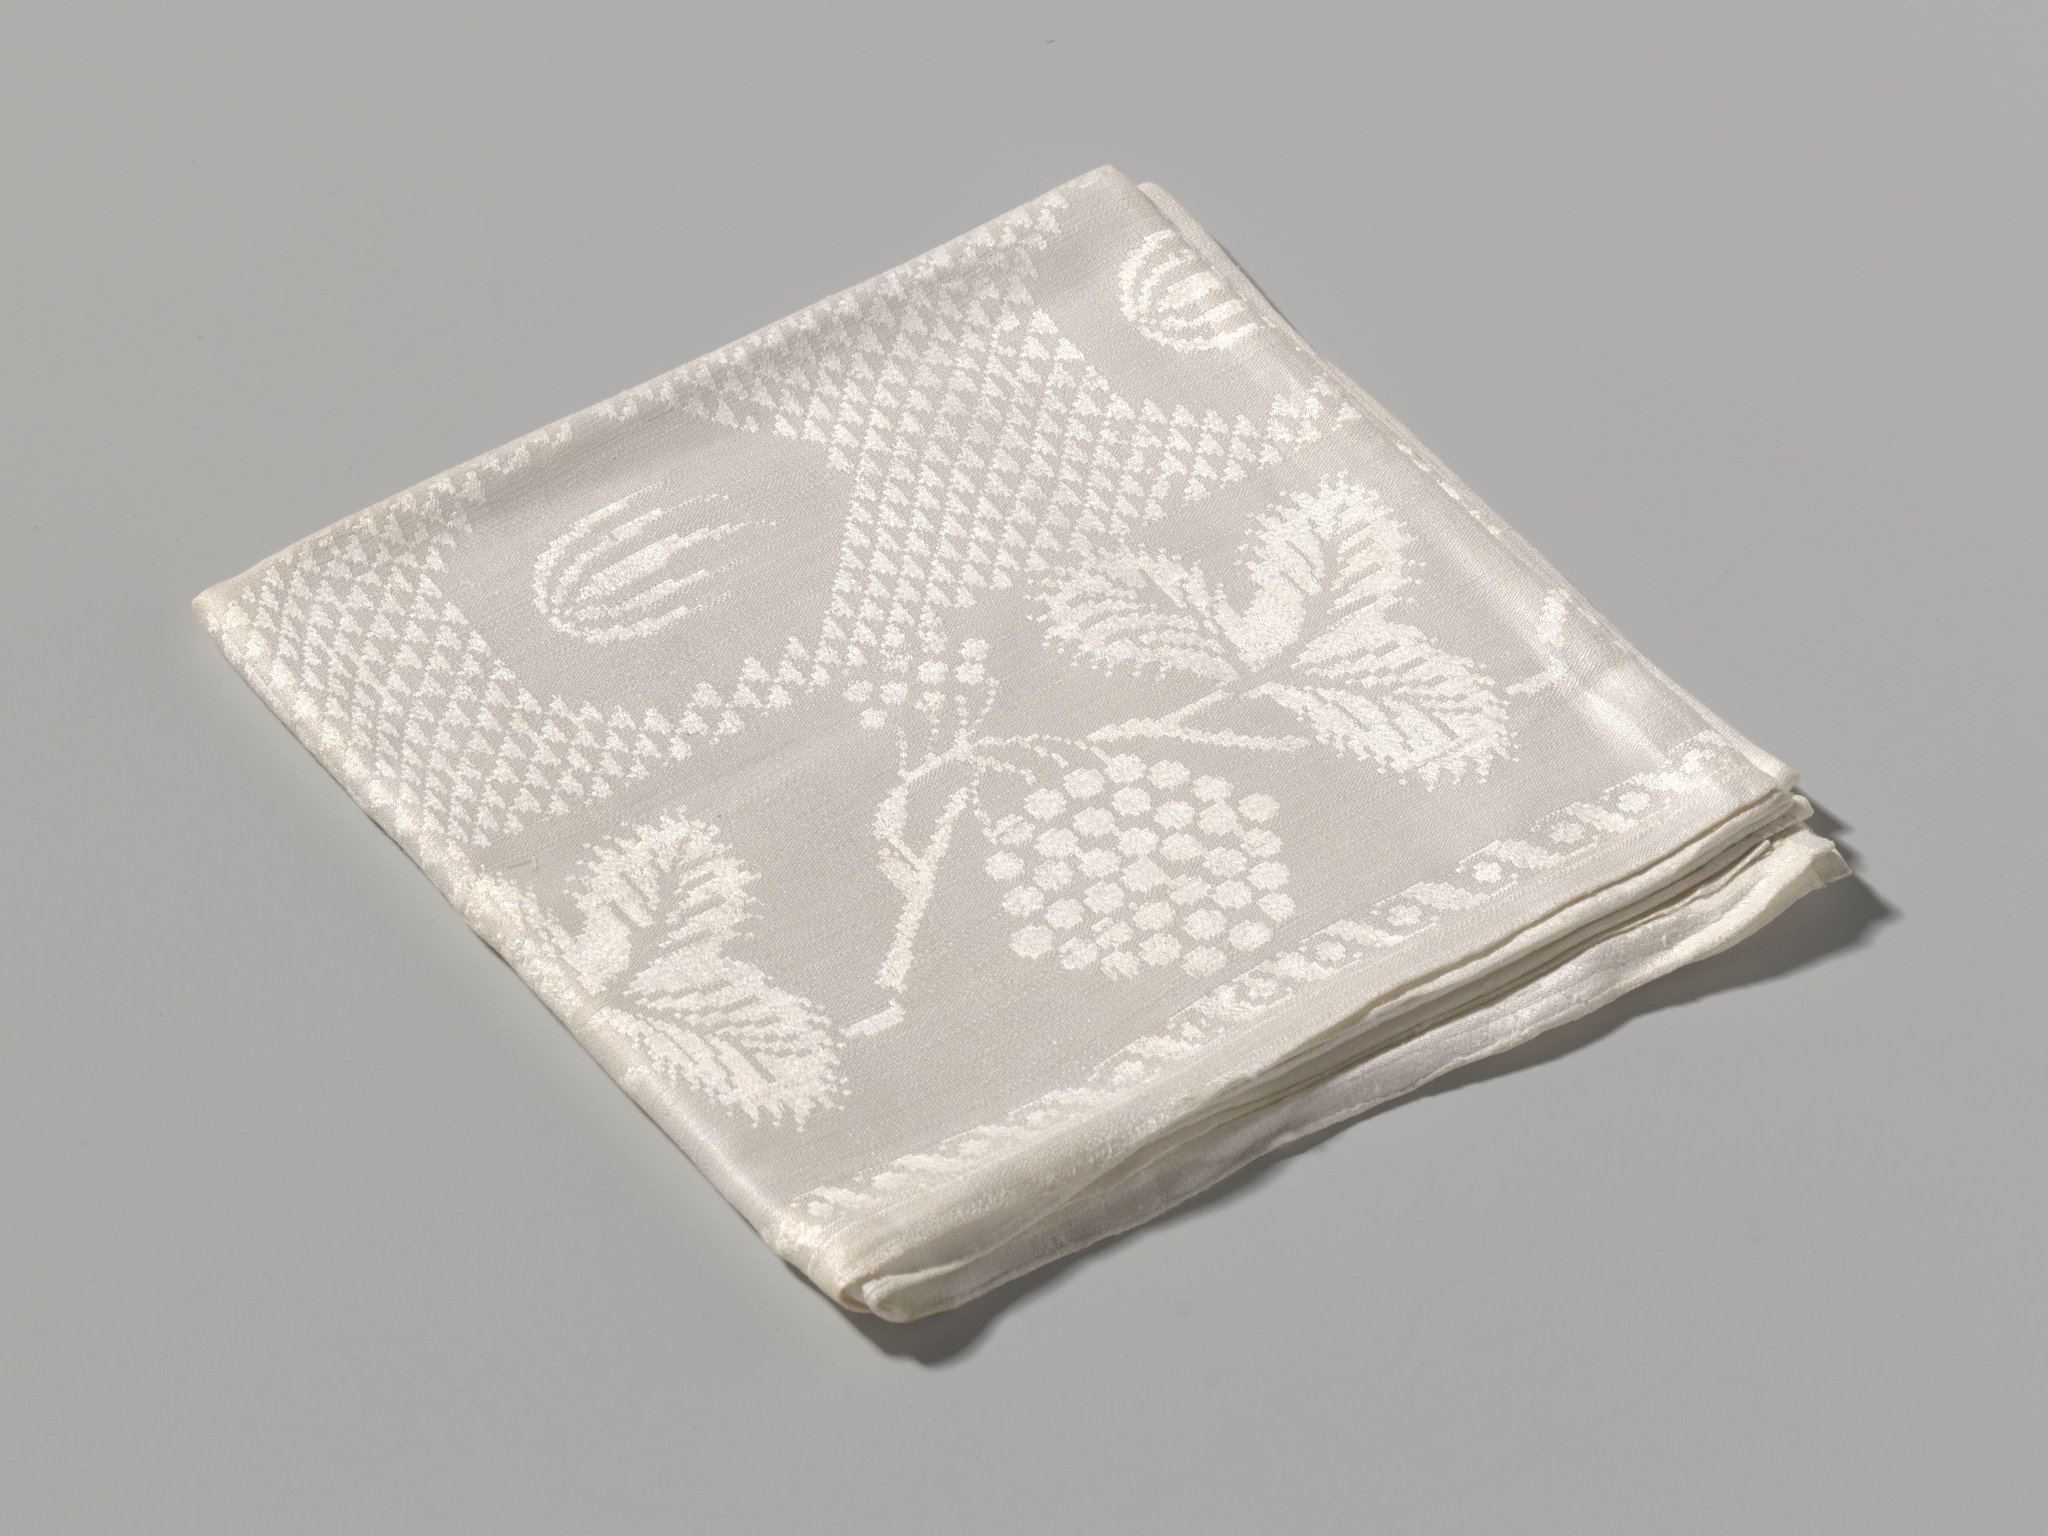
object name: napkin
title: Servet met rand van druivenranken en een geschaakt midden met inzetten.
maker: Anonymous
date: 1825-1850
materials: linen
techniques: damask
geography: germany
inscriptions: mark: ‘A.W. io E Small’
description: Wit linnen damasten servet met een rand van druivenranken en een geschaakt midden met inzetten.